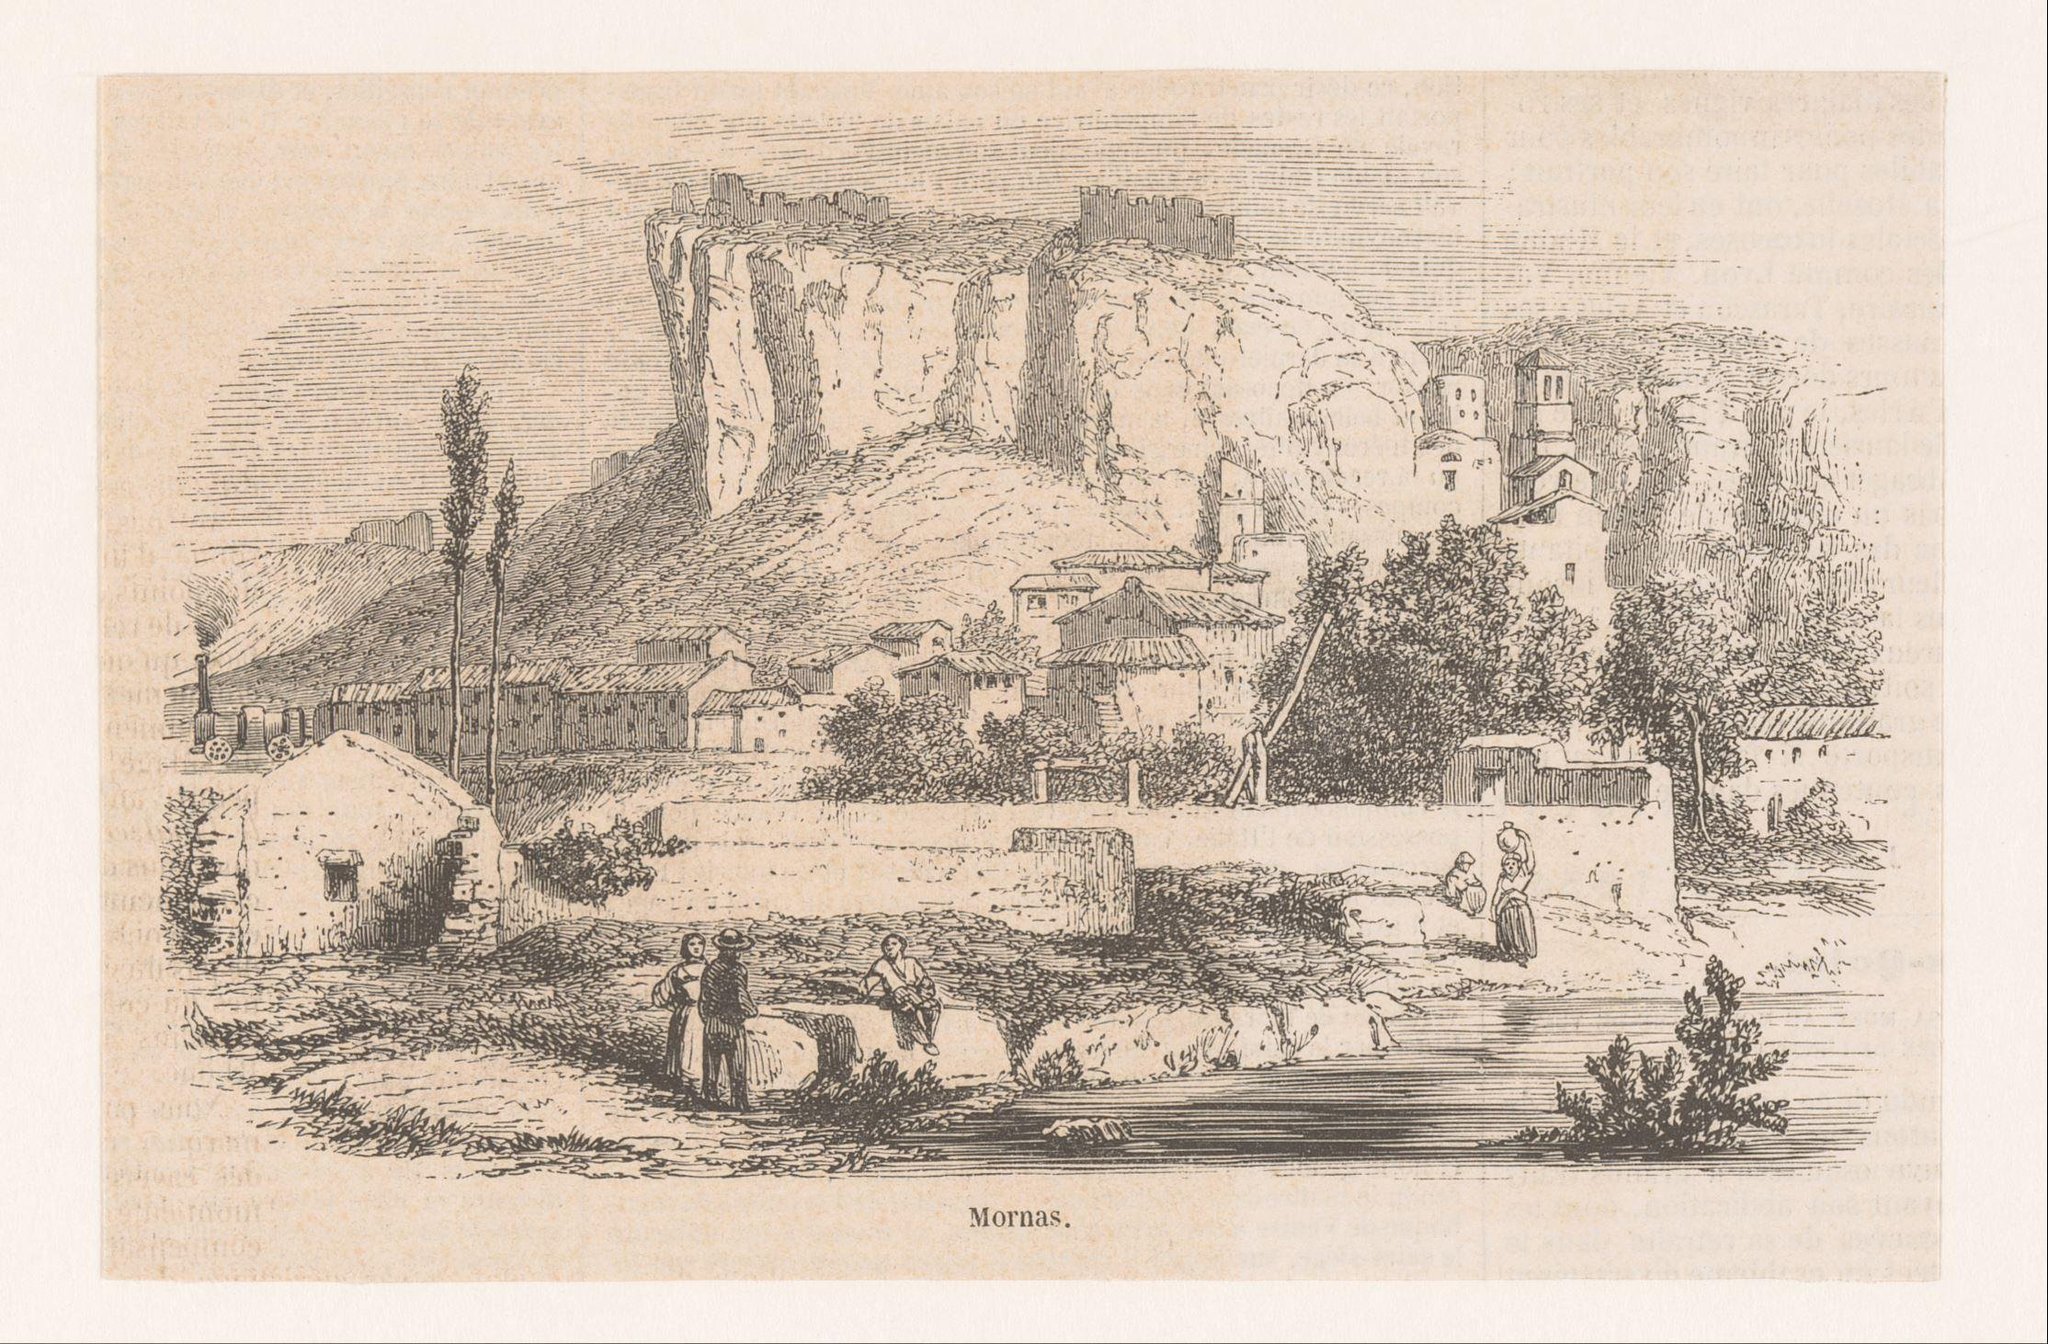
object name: print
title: Gezicht op Mornas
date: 1854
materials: paper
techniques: letterpress printing, engraving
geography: paris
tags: city-view, and landscape with man-made constructions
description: Prent uit: L'Illustration, vol. 25, nr. 592, 1 juli 1854, p. 13.